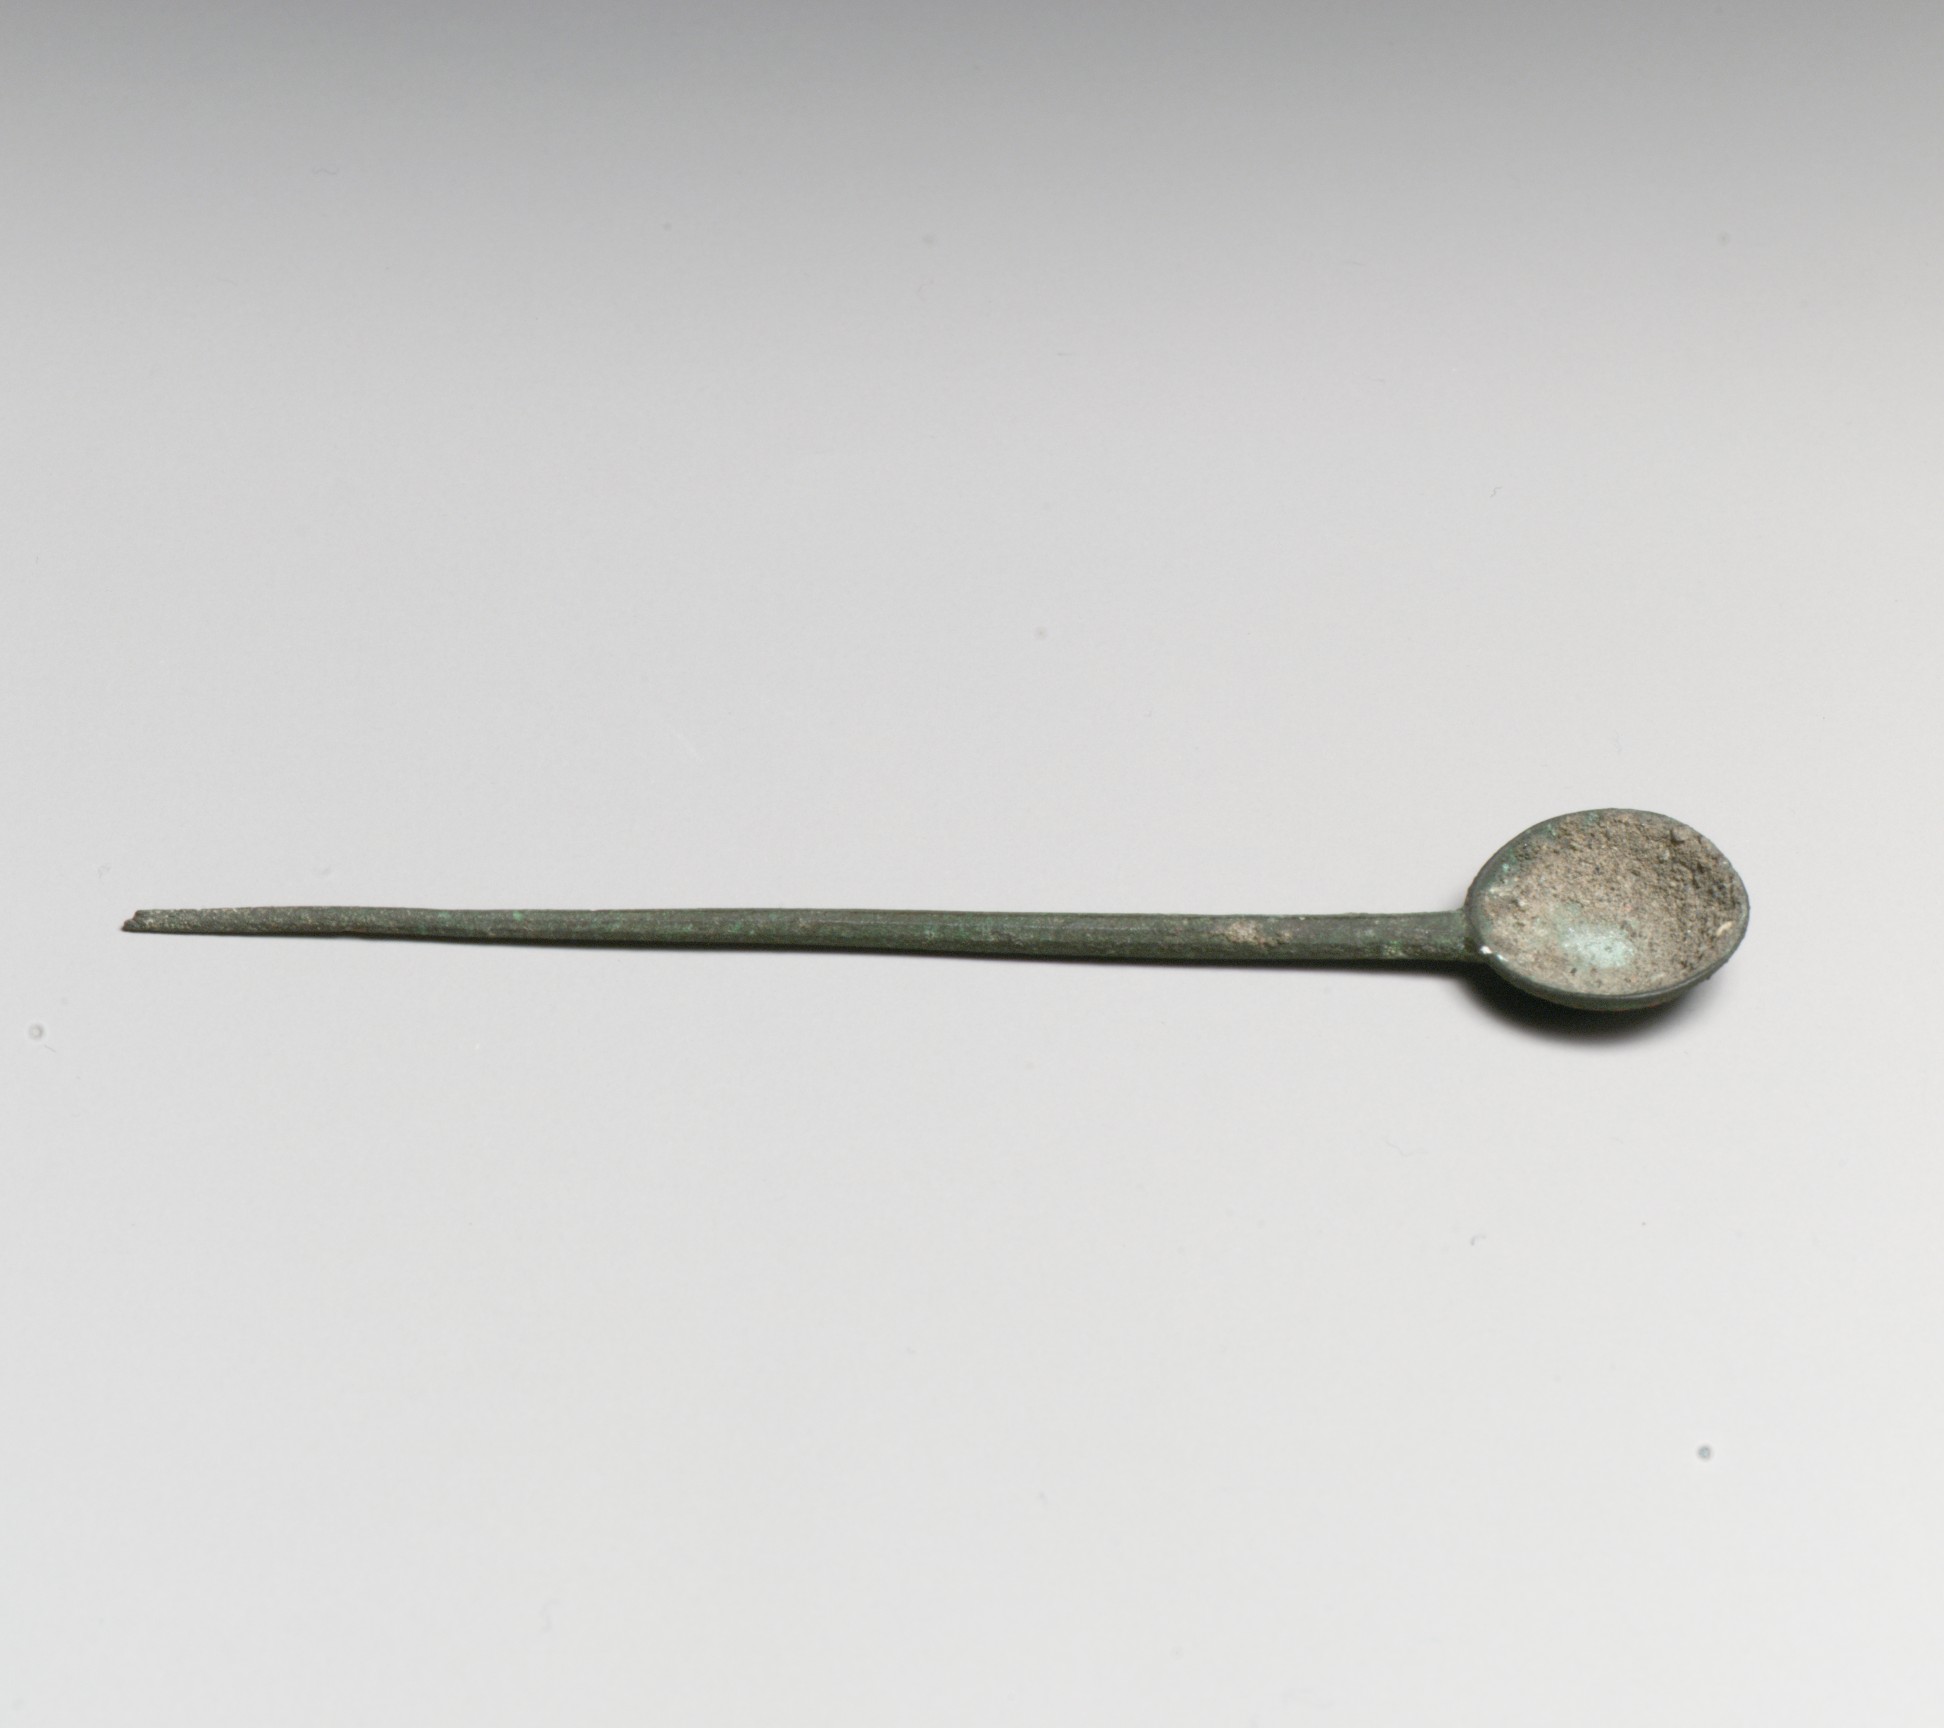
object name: spoon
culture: roman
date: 670 BCE-330 CE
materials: bronze